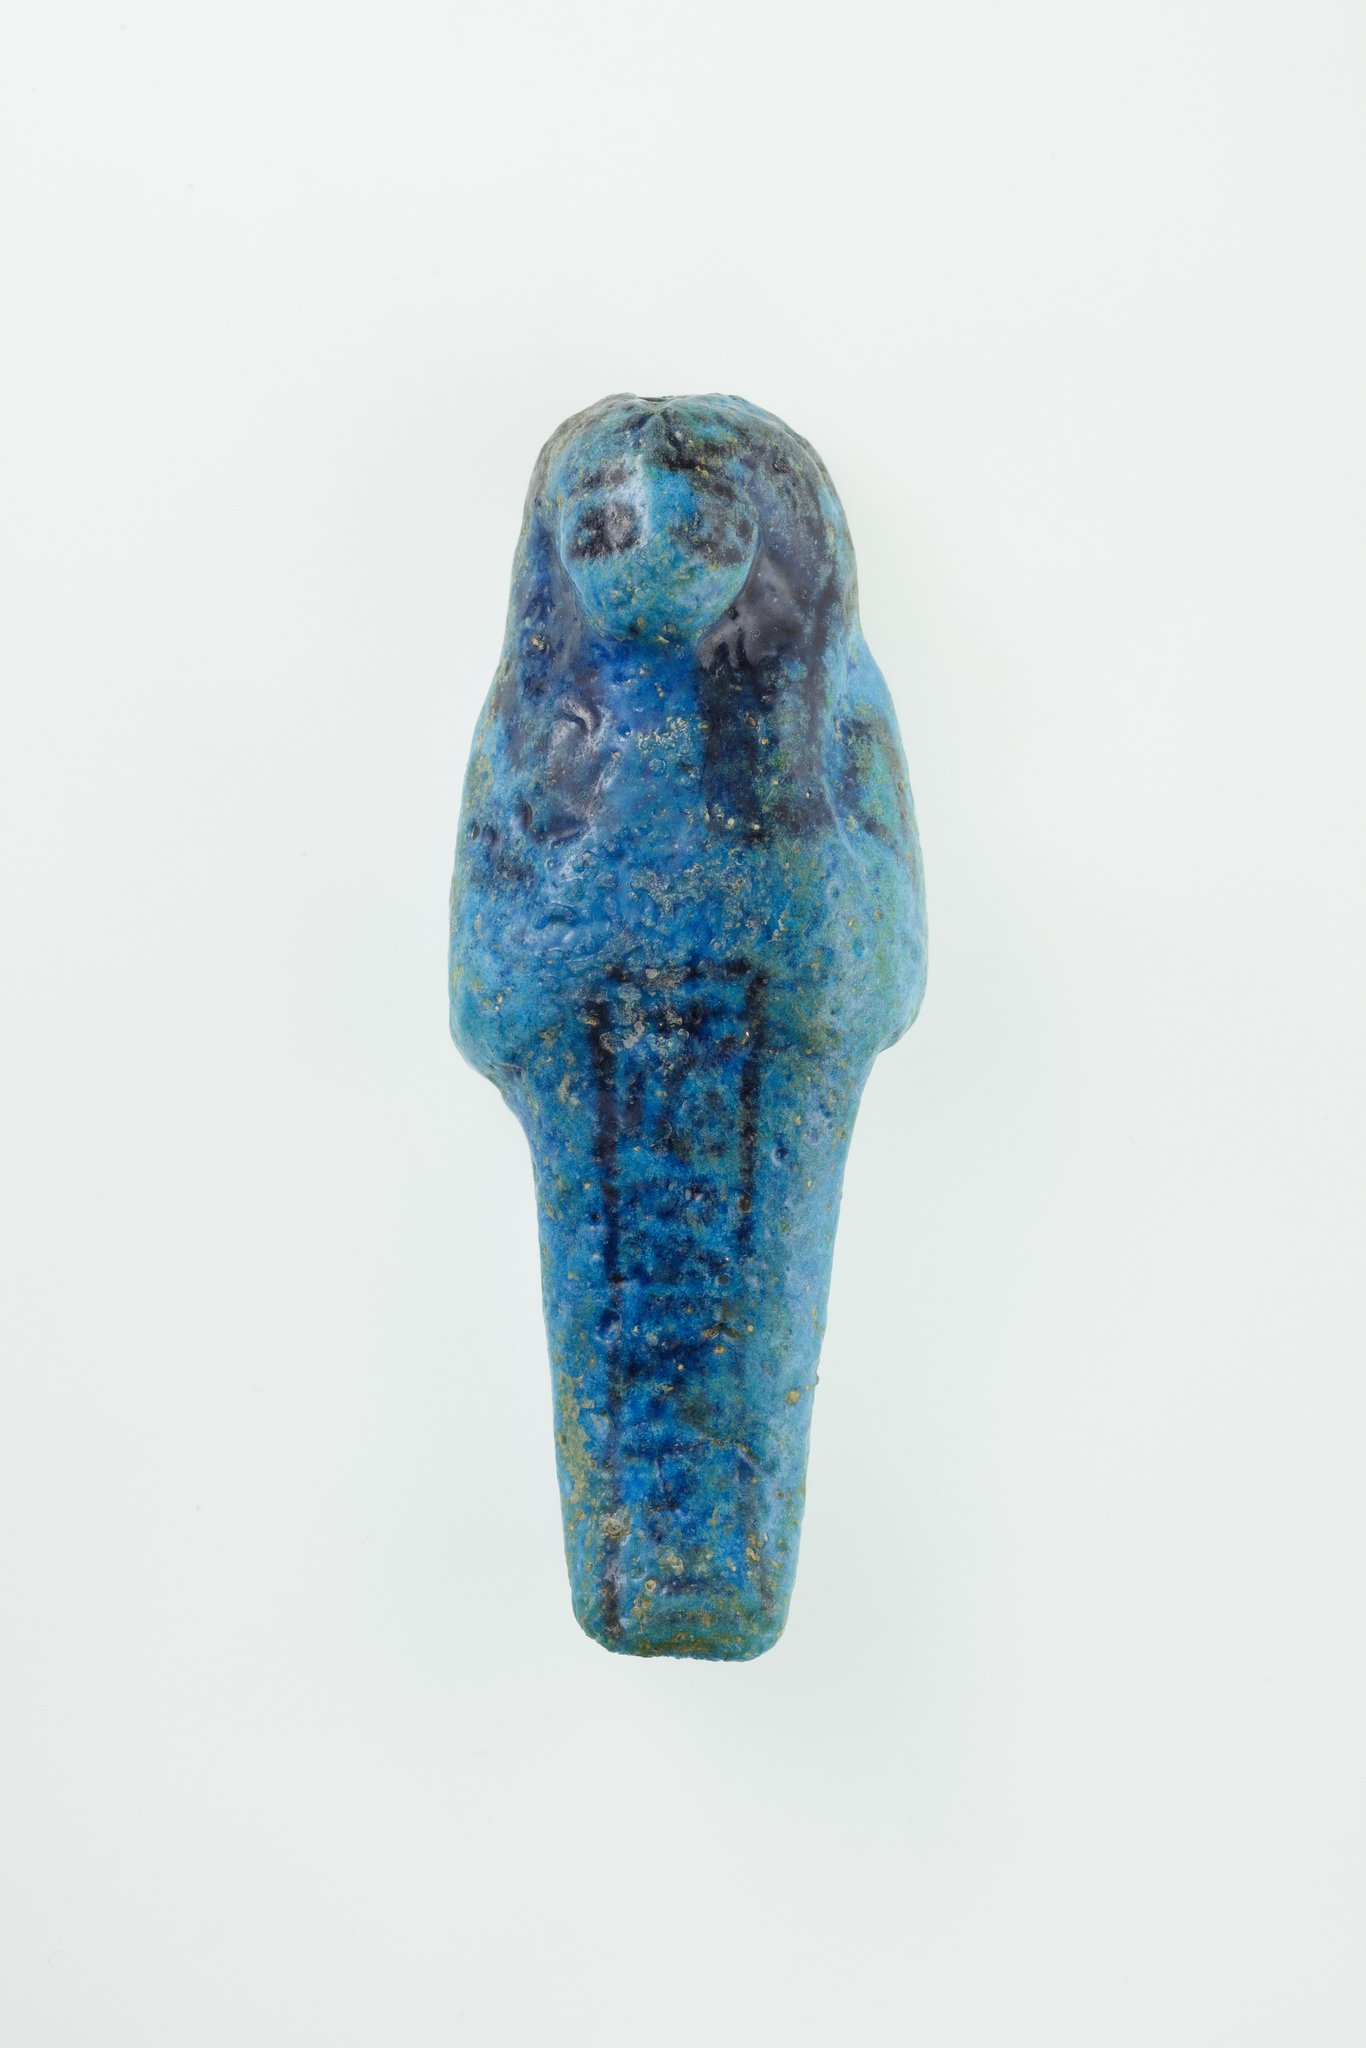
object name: shabti, worker, nauny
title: Worker Shabti of Nauny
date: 1050 BCE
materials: faience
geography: egypt